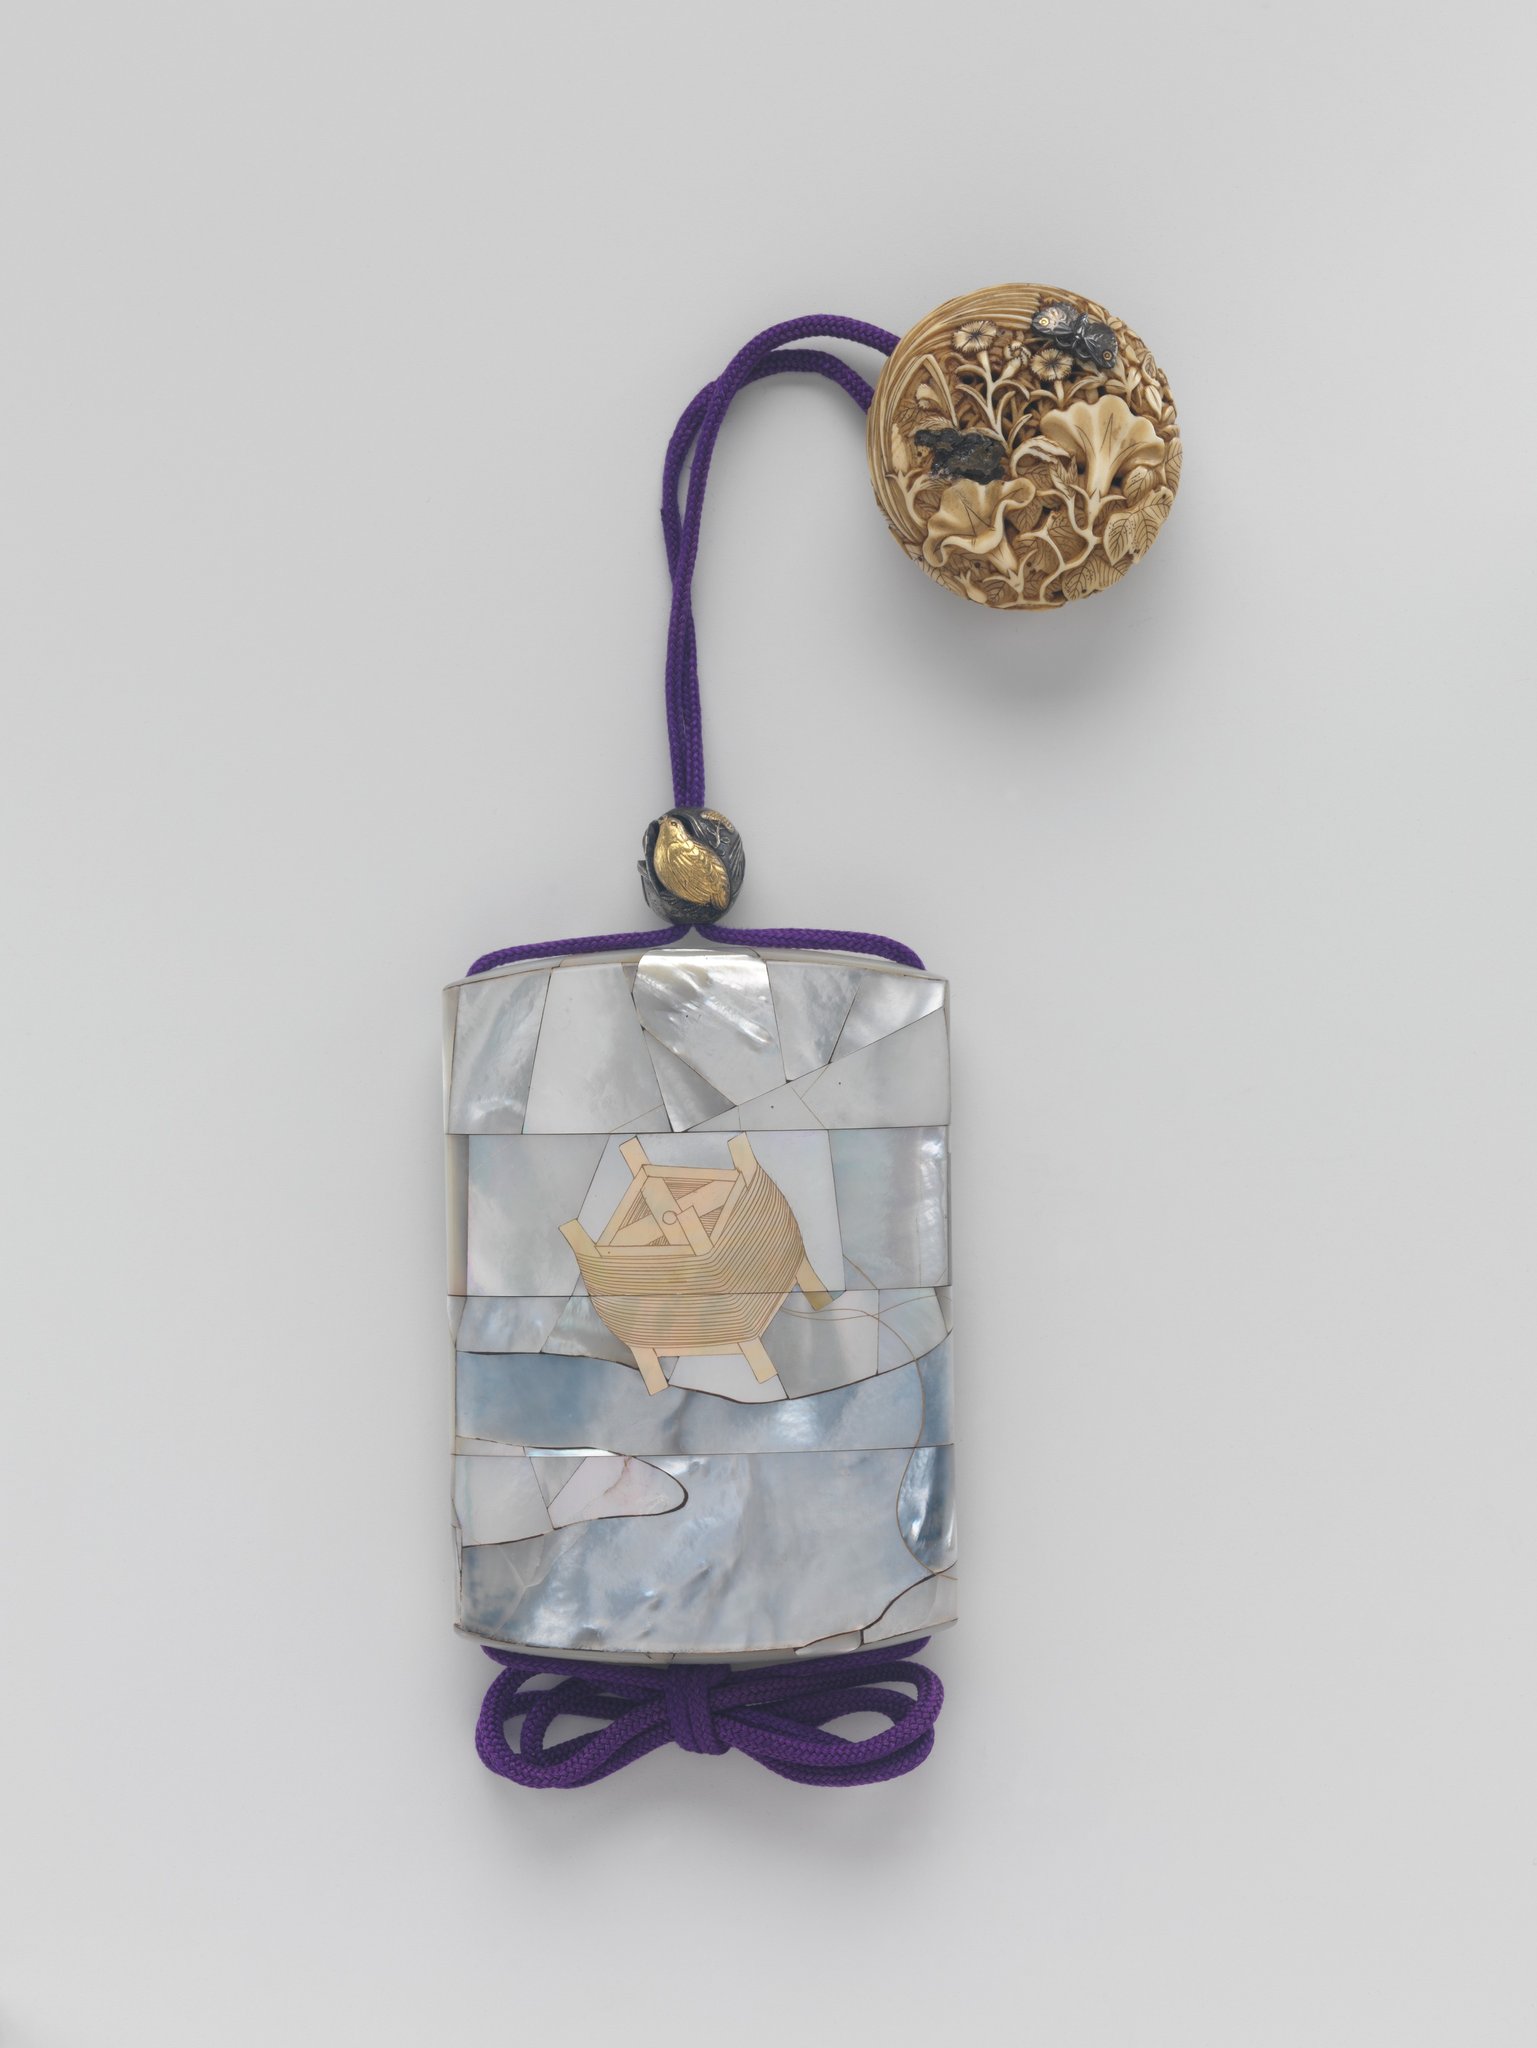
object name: inrō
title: Inrō with Tanabata Story of the Weaver and the Herdboy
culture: japanese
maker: nomura kyūkoku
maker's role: artist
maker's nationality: japanese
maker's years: 1800-1849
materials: gold, ivory, mother of pearl, silver, wood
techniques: carving, hiramakie, inlay, lacquer